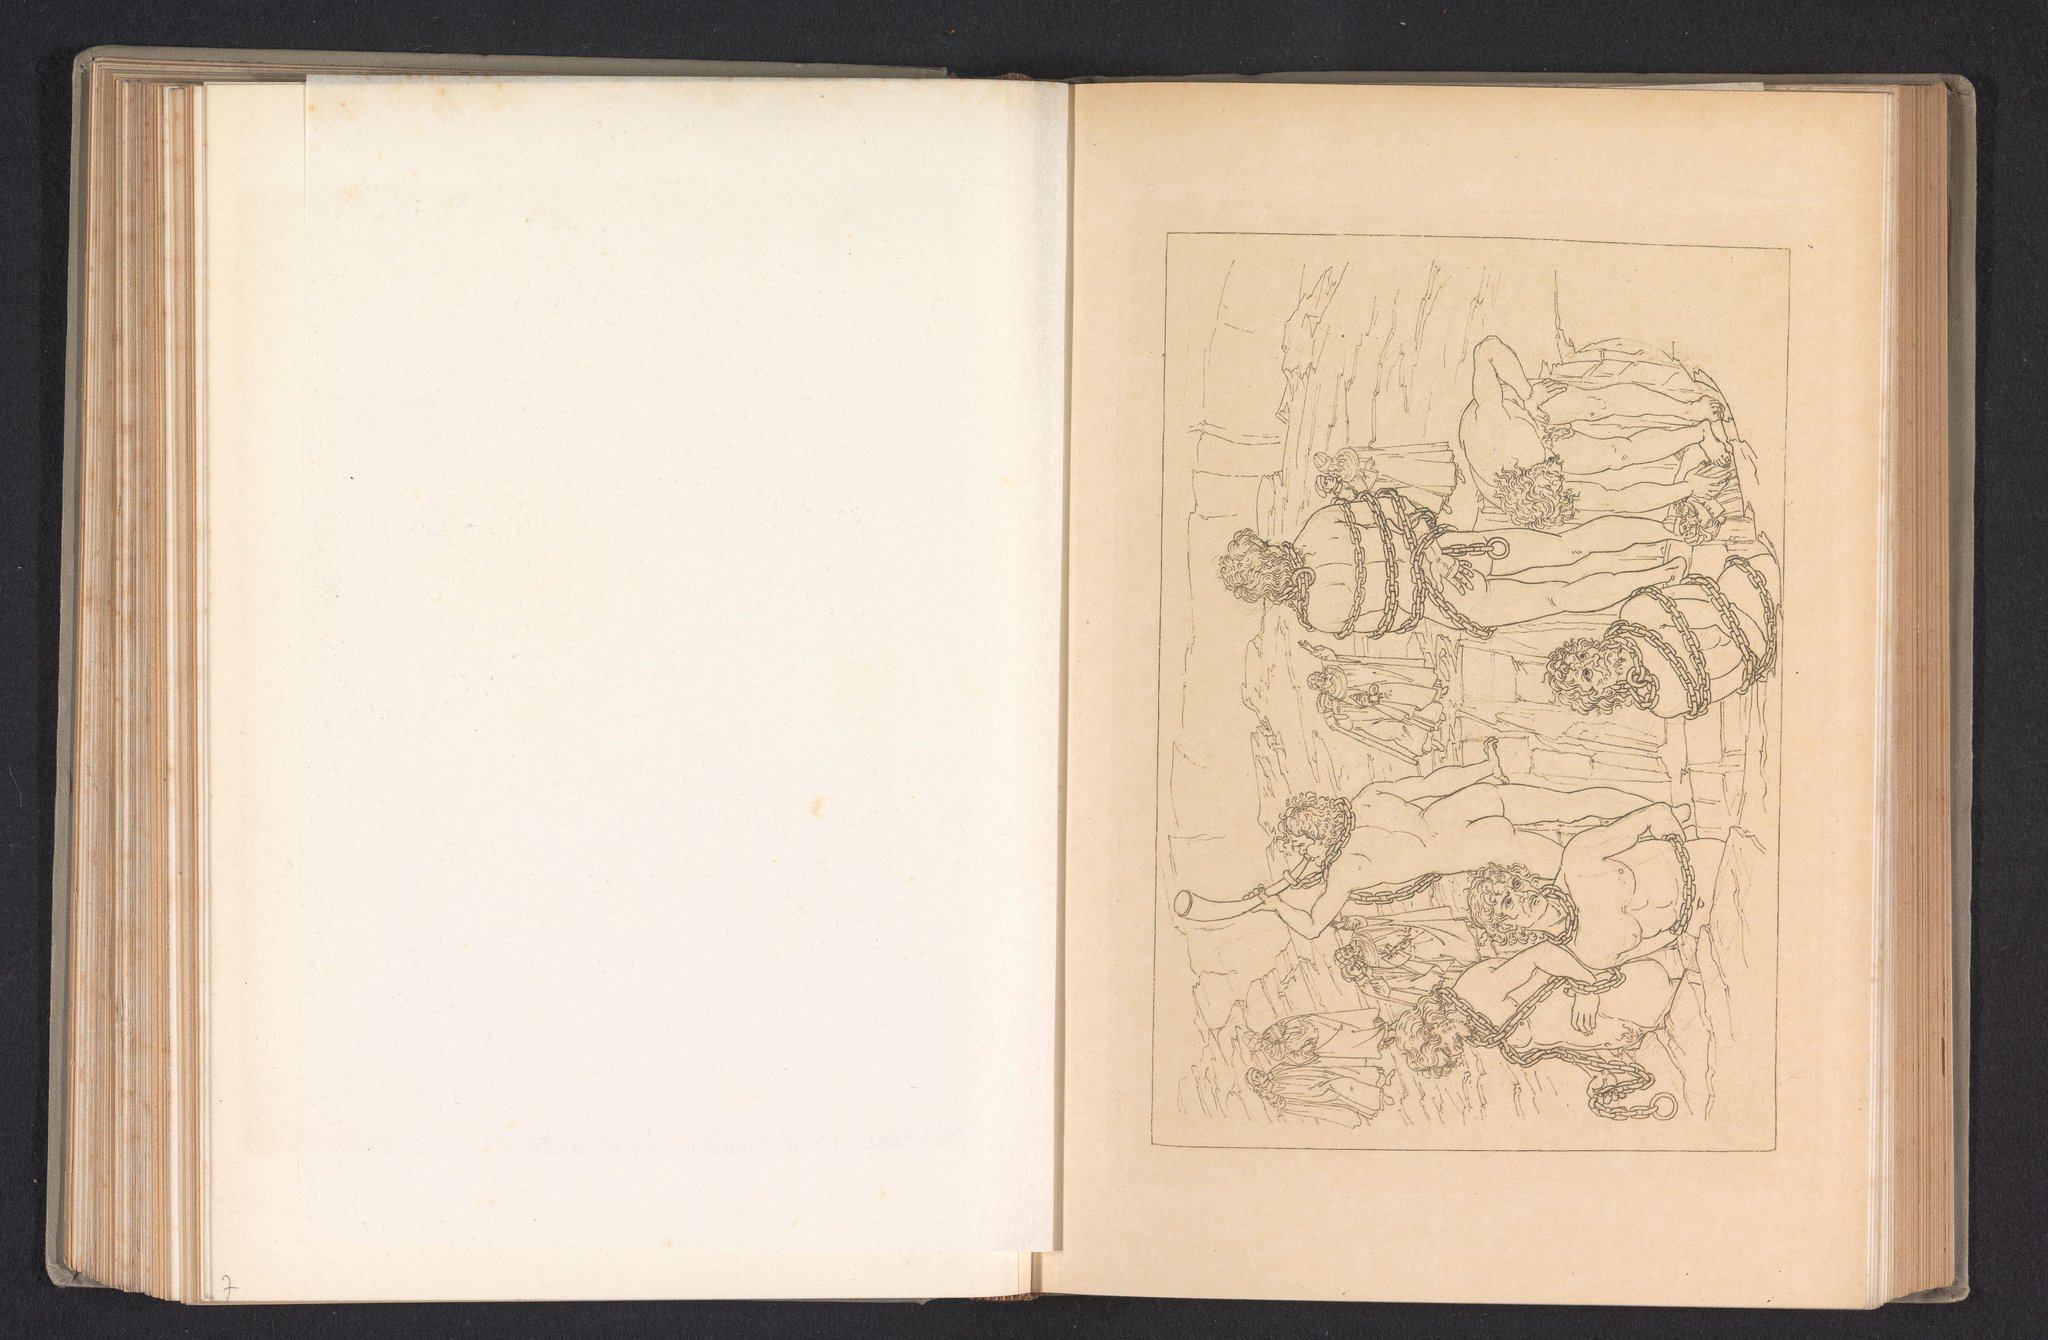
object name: page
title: Fotoreproductie van een prent, voorstellende (vermoedelijk) zes geketende reuzen in een gat in de grond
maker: Anonymous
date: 1878-1883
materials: paper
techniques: photoaquatint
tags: pit, hole, giants, colossi